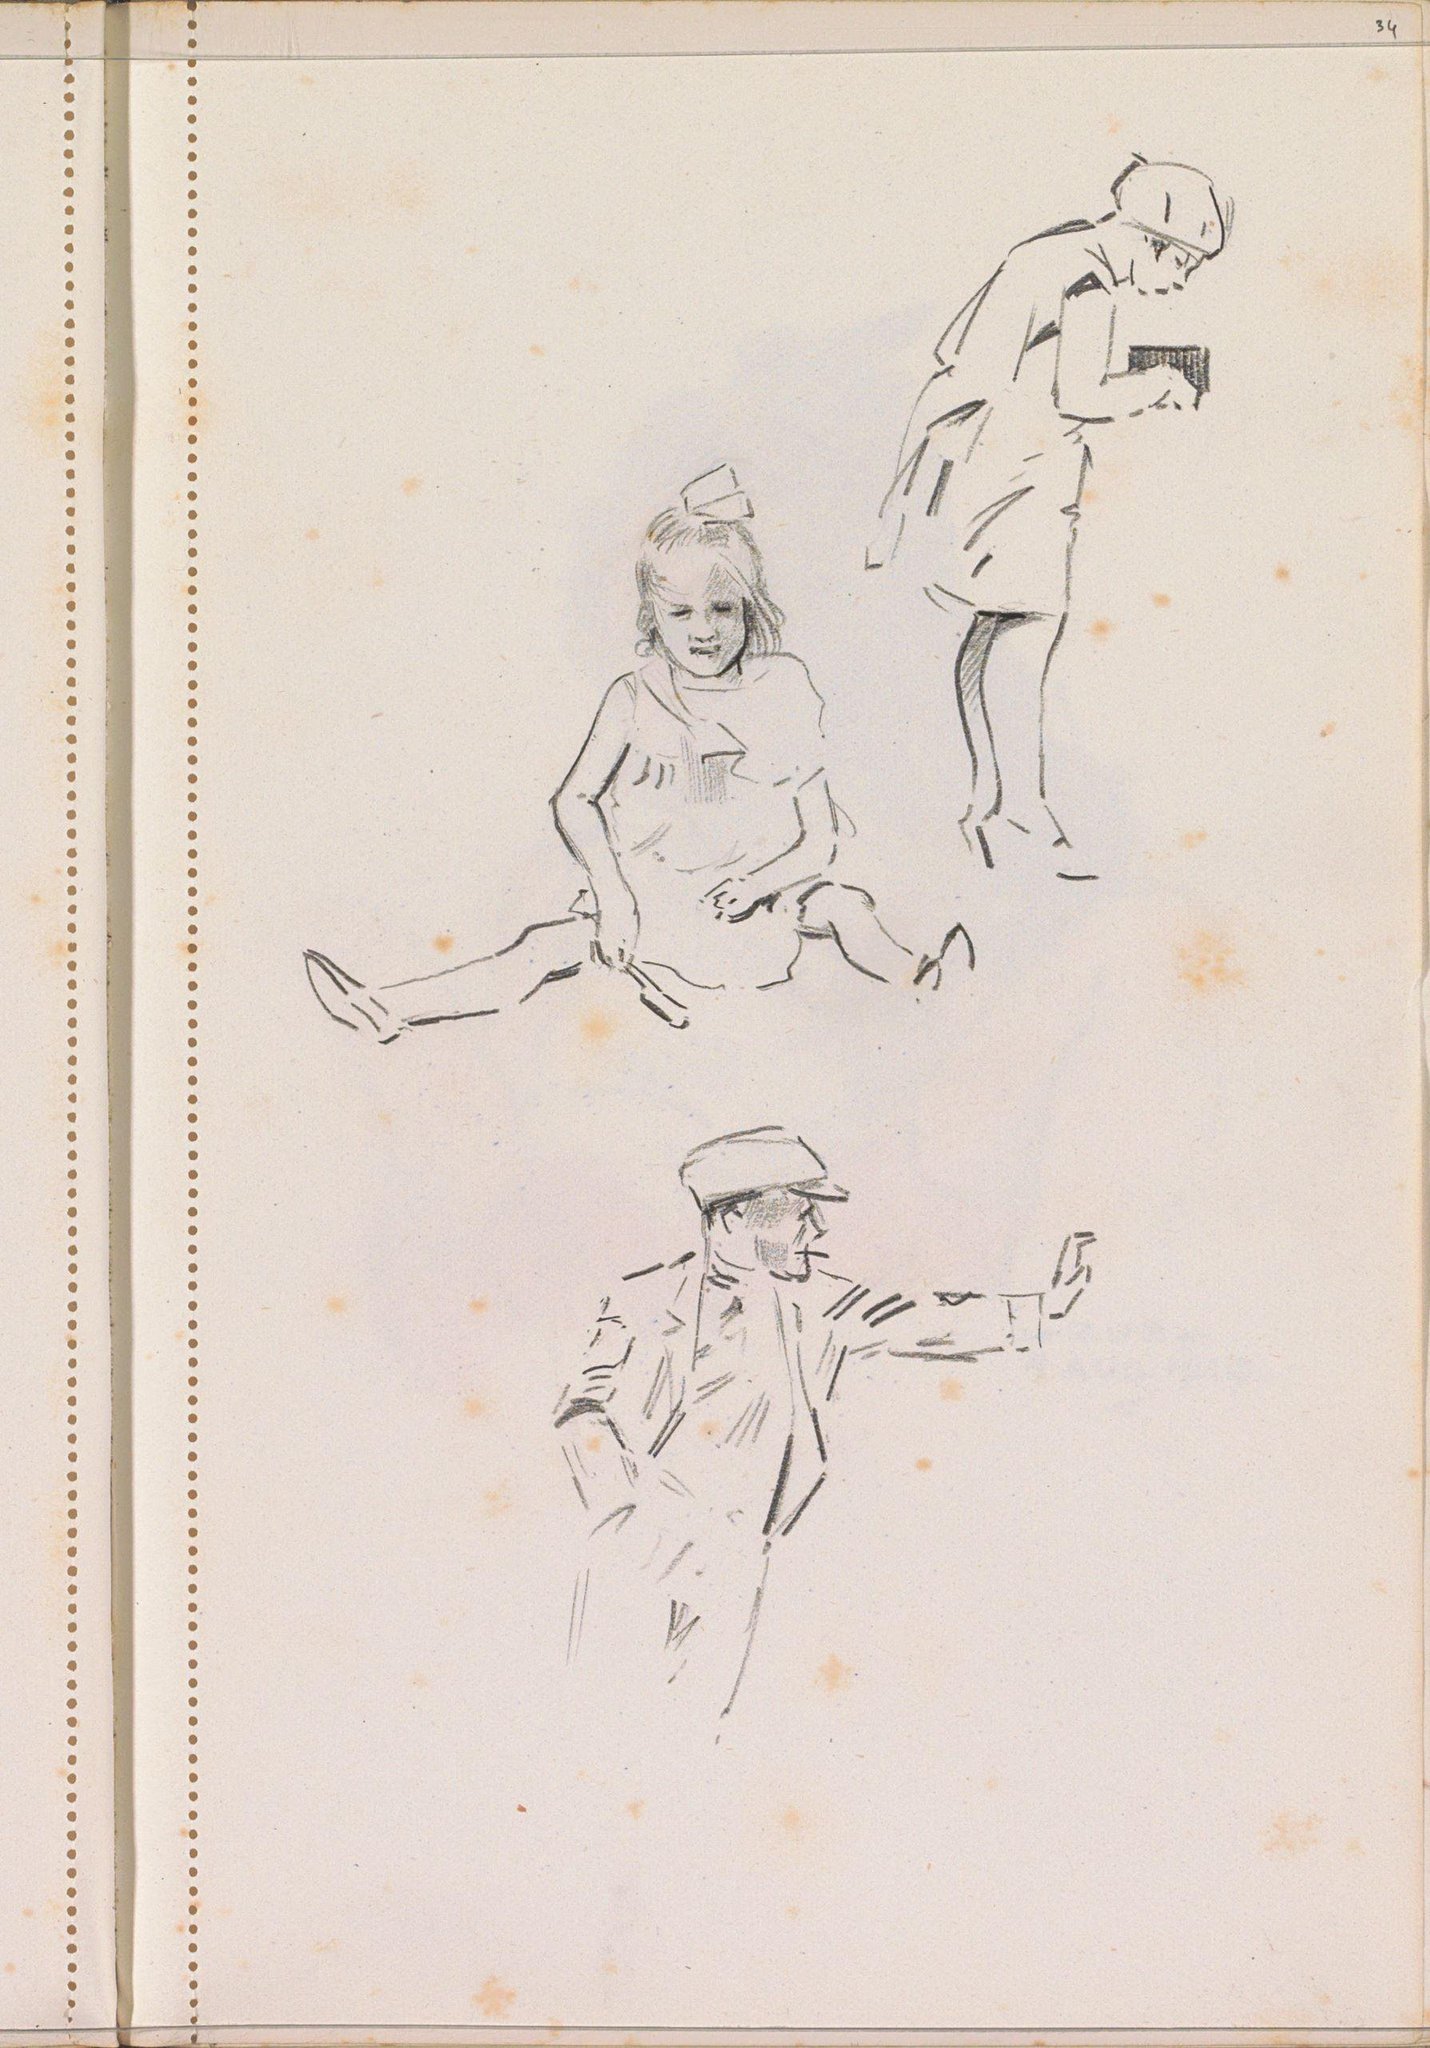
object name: sketchbook leaf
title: Spelend en lezend meisje en een jongen met een opgeheven arm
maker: otto verhagen (i)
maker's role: draughtsman, print maker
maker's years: 1885-1951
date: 1928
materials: chalk, paper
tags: reading, arm stretched forward (+ male human being (not to be used where -a- is prescribed)), girl (child between toddler and youth)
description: Pagina 34 uit een schetsboek met 51 bladen.